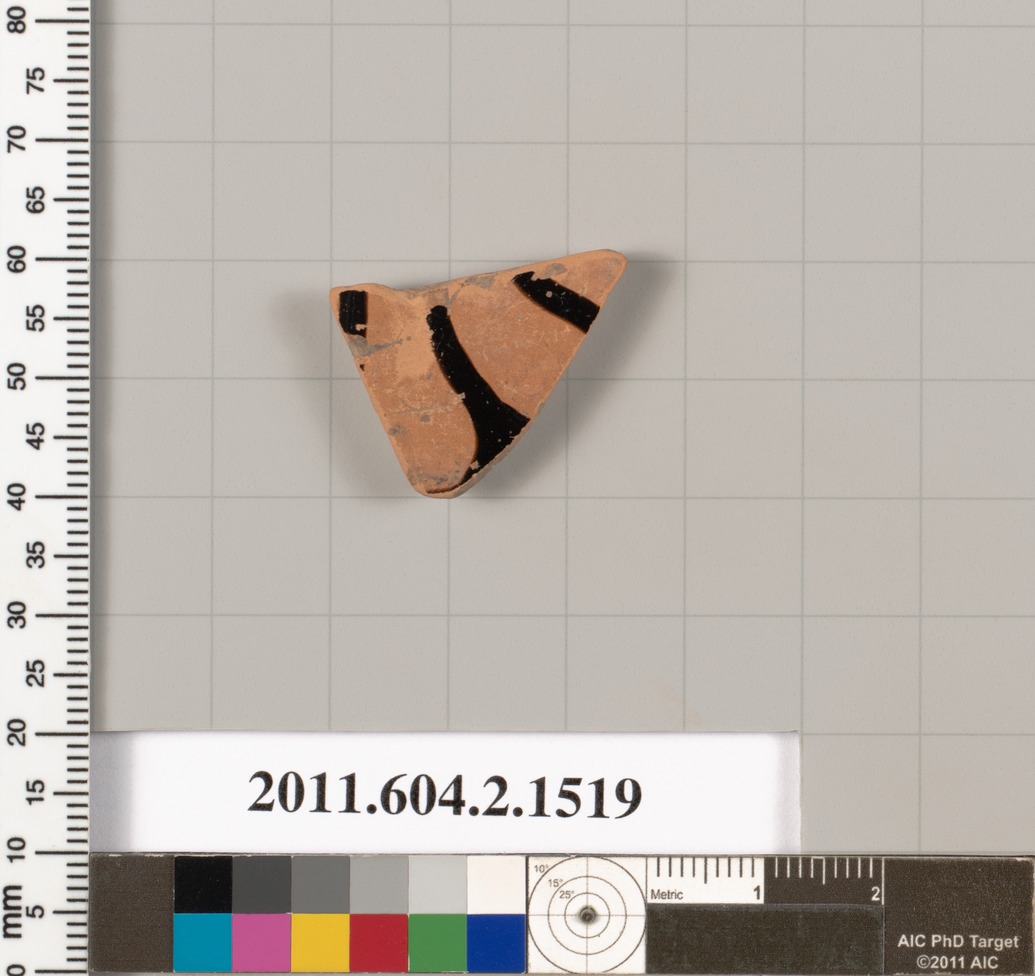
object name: skyphos fragment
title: Terracotta fragment of a skyphos (deep drinking cup)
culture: greek, attic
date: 475-451 BCE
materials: terracotta